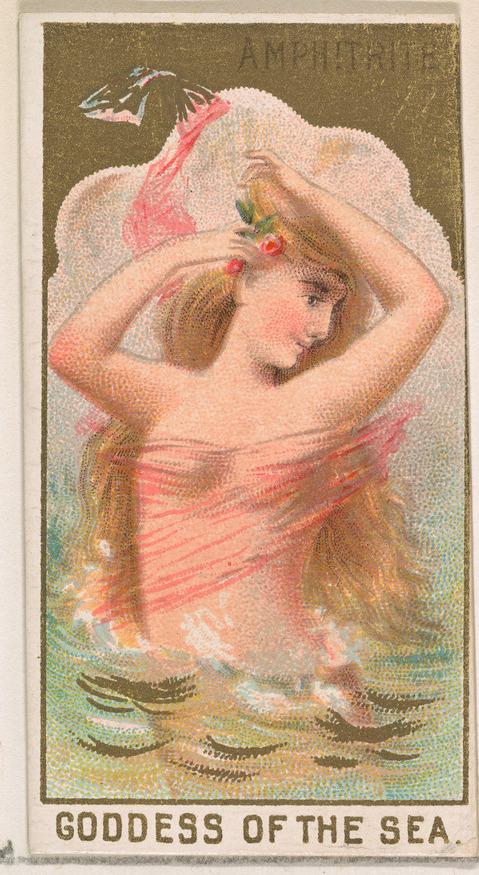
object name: print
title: Amphitrite, Goddess of the Sea, from the Goddesses of the Greeks and Romans series (N188) issued by Wm. S. Kimball & Co.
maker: william s. kimball & company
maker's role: publisher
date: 1889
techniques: color lithograph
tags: goddess